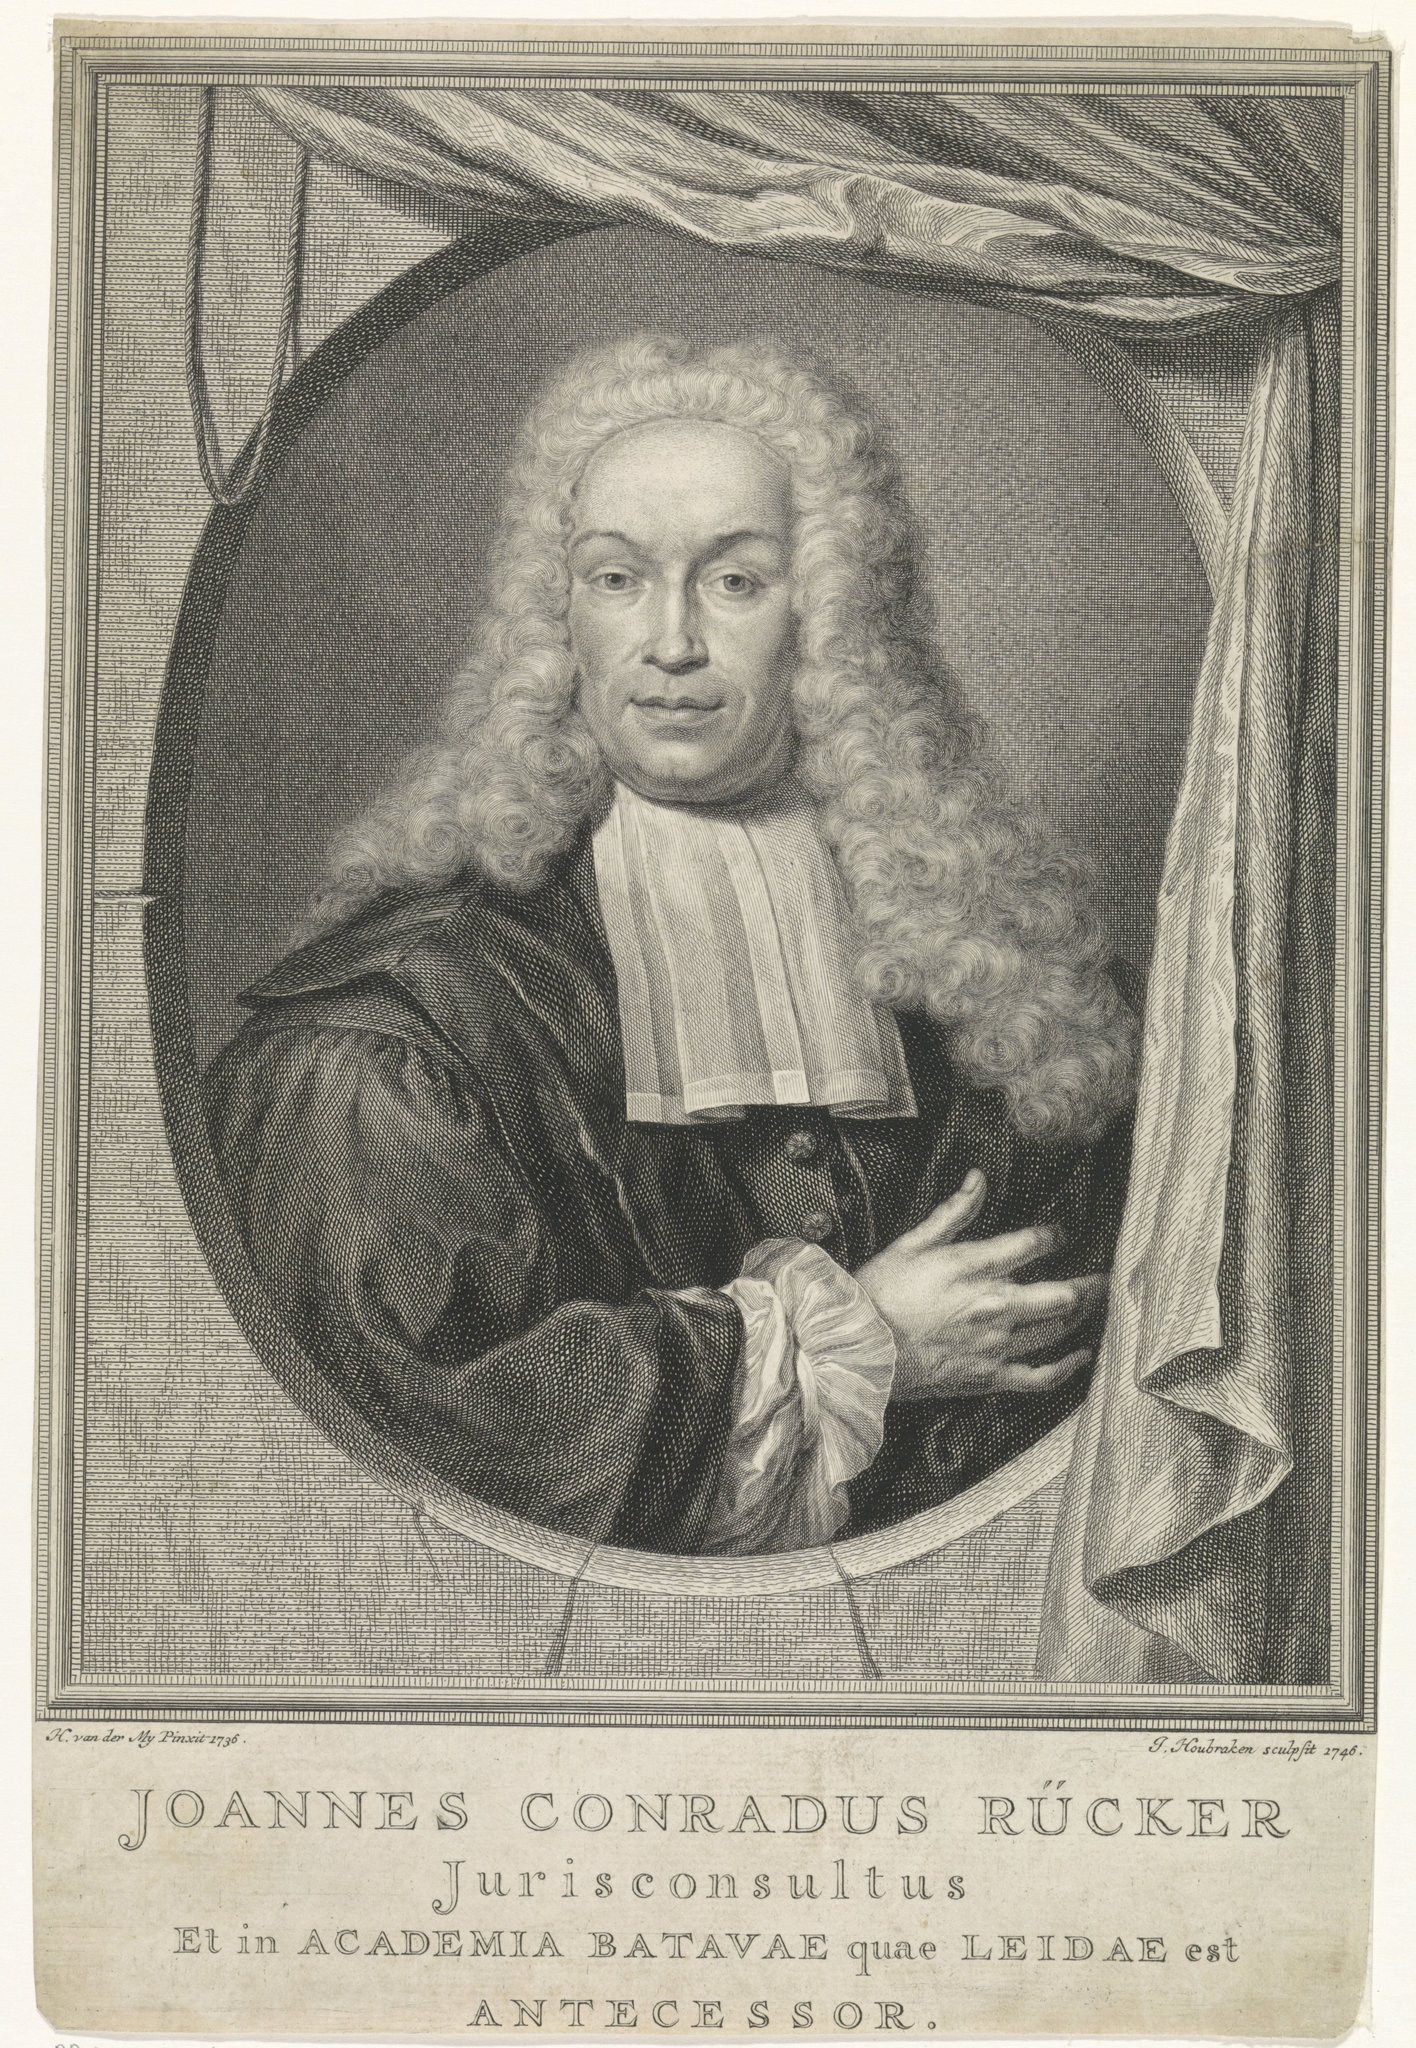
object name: print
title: Joannes Conradus Rücker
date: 1746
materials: paper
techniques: engraving, etching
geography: leiden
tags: leiden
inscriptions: collector's mark: Lugt 2228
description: Portret ten halven lijve van Johann Conrad Rücker in een ovaal architectonisch venster, waarvoor rechts en rechtsboven een deel van een gordijn. Onder het portret zijn naam en gegevens in vier regels in het Latijn.